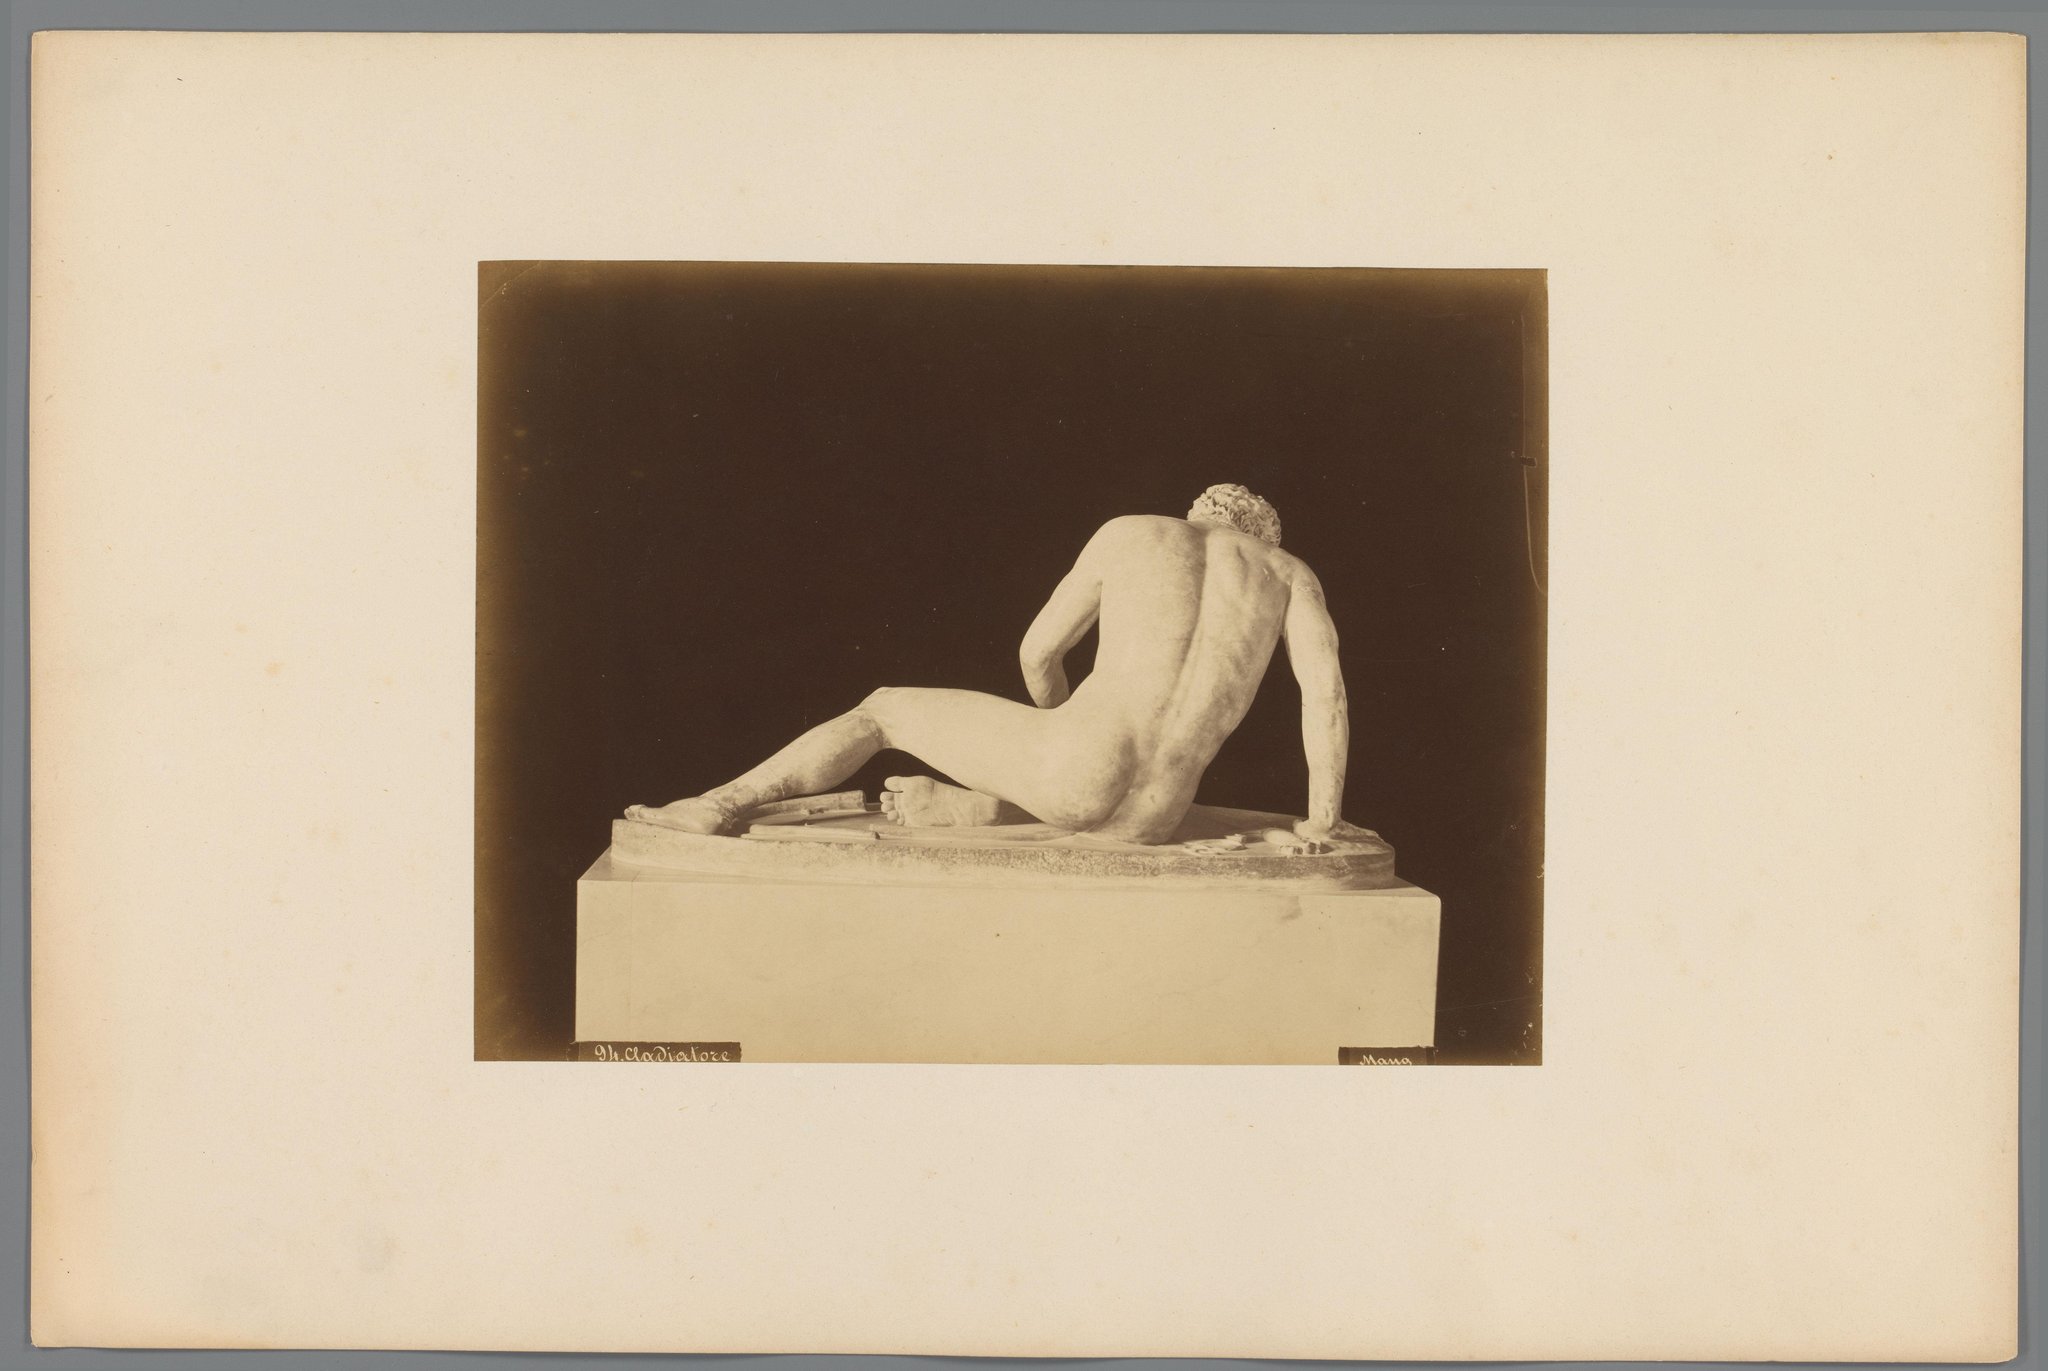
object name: photograph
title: Sculptuur De Stervende Galliër in de Capitolijnse Musea te Rome, Italië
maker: michèle mang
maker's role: fotograaf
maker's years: 1840-1909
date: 1863-1887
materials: cardboard, paper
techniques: albumen print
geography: rome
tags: piece of sculpture, reproduction of a piece of sculpture, dying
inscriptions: number: ‘94.’, number: ‘11’